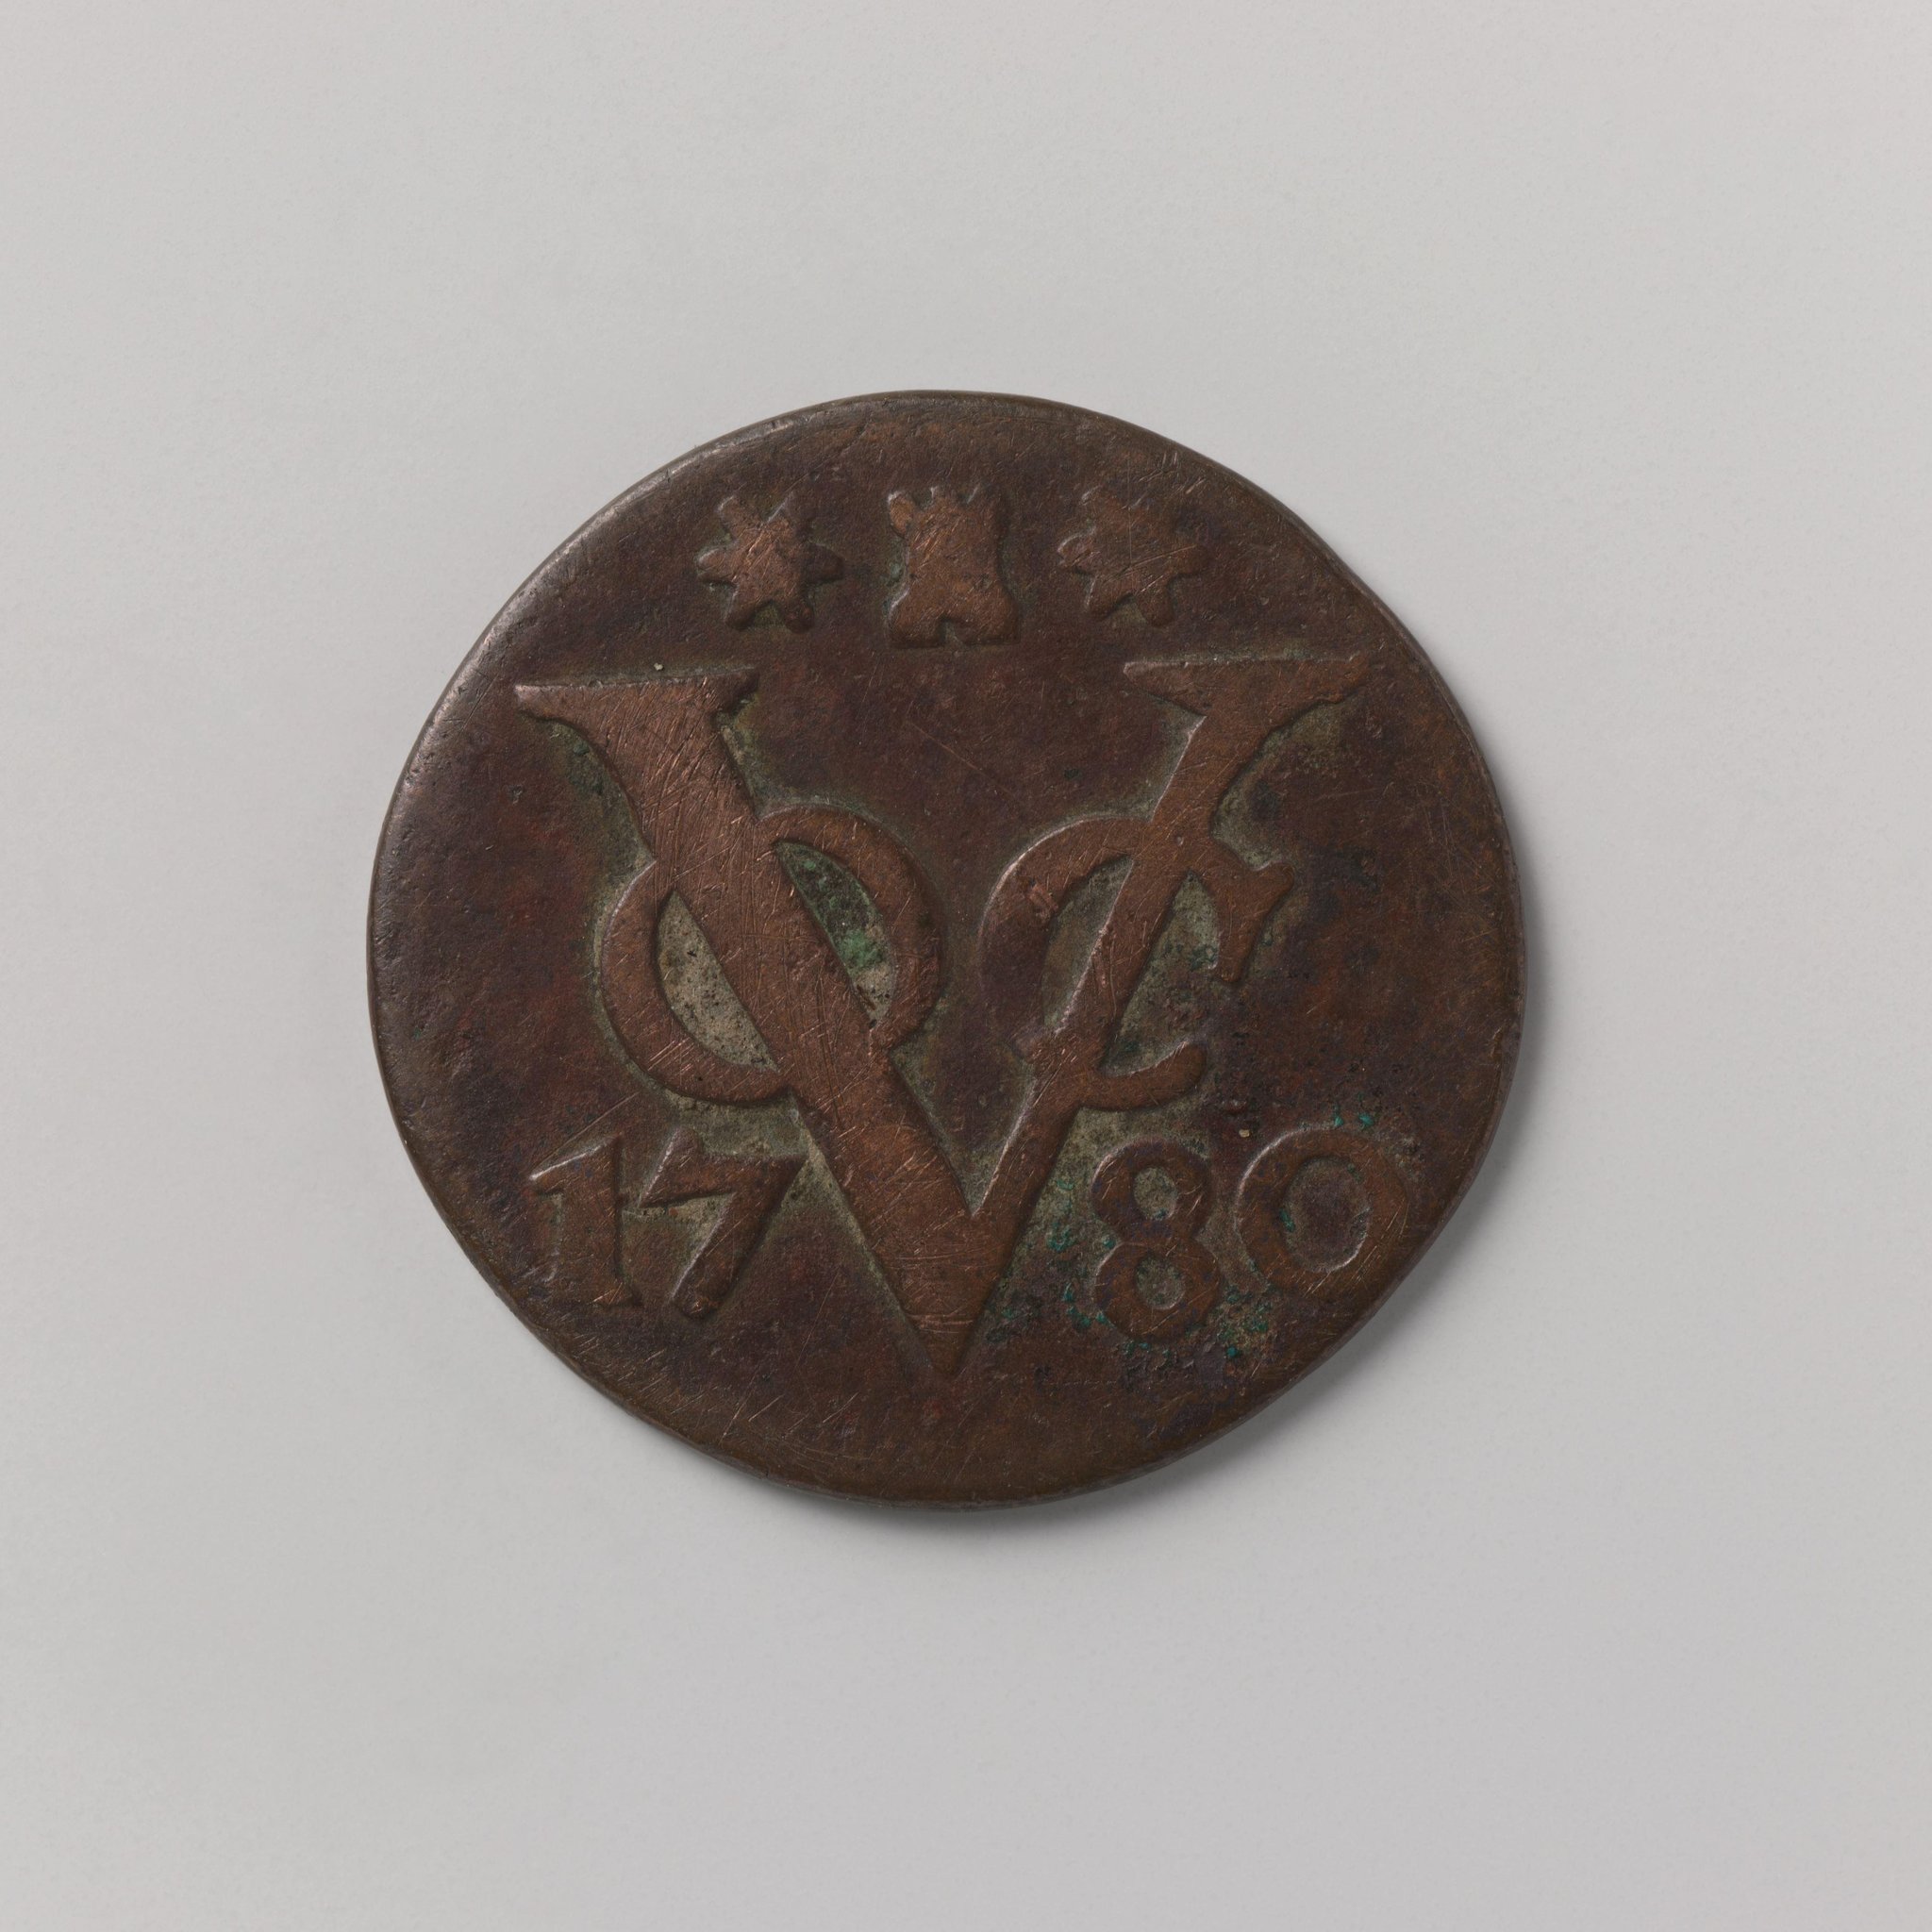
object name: coin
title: VOC, duit Zeeland, 1780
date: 1780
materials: copper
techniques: striking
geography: middelburg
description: Koperen munt. Voorzijde: gekroond wapenschild van Zeeland. Keerzijde: monogram van de VOC, waarboven muntteken en waaronder jaartal. Gladde rand.